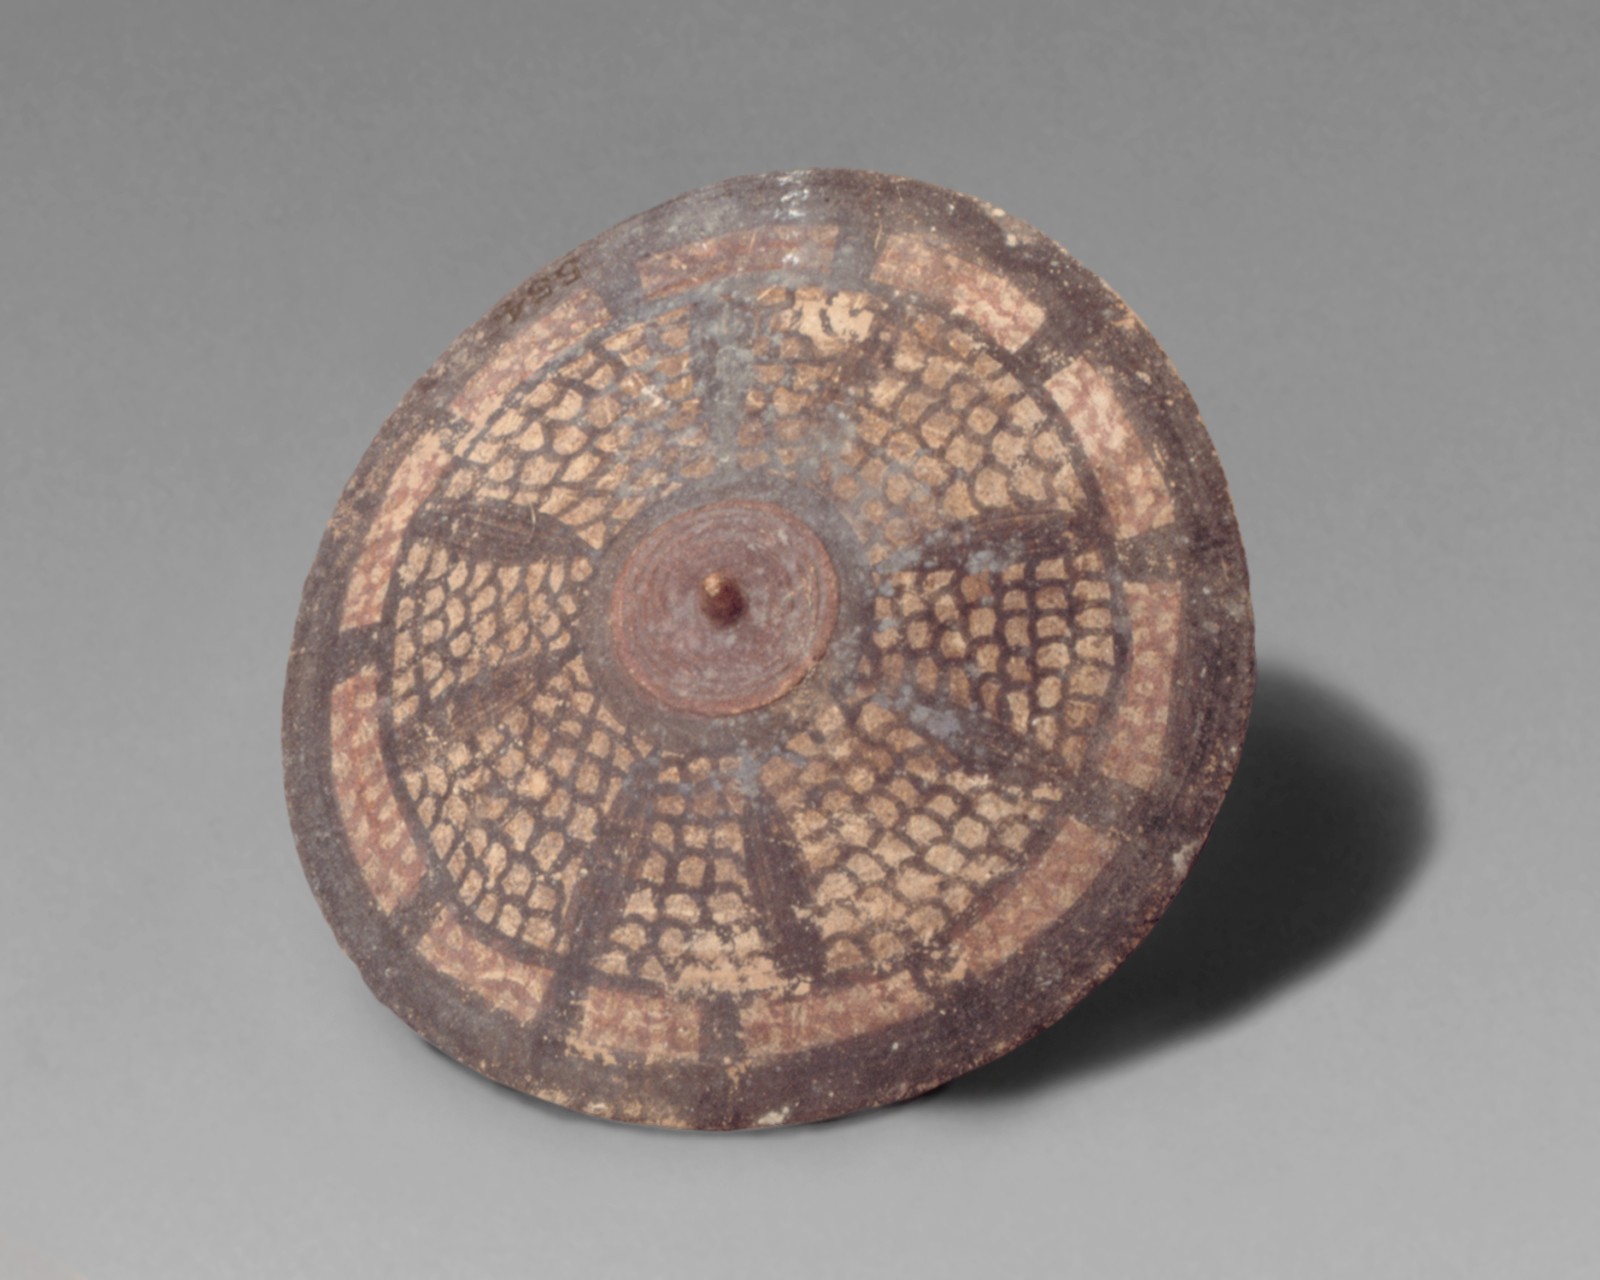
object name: shield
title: Terracotta shield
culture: cypriot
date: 600-480 BCE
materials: terracotta